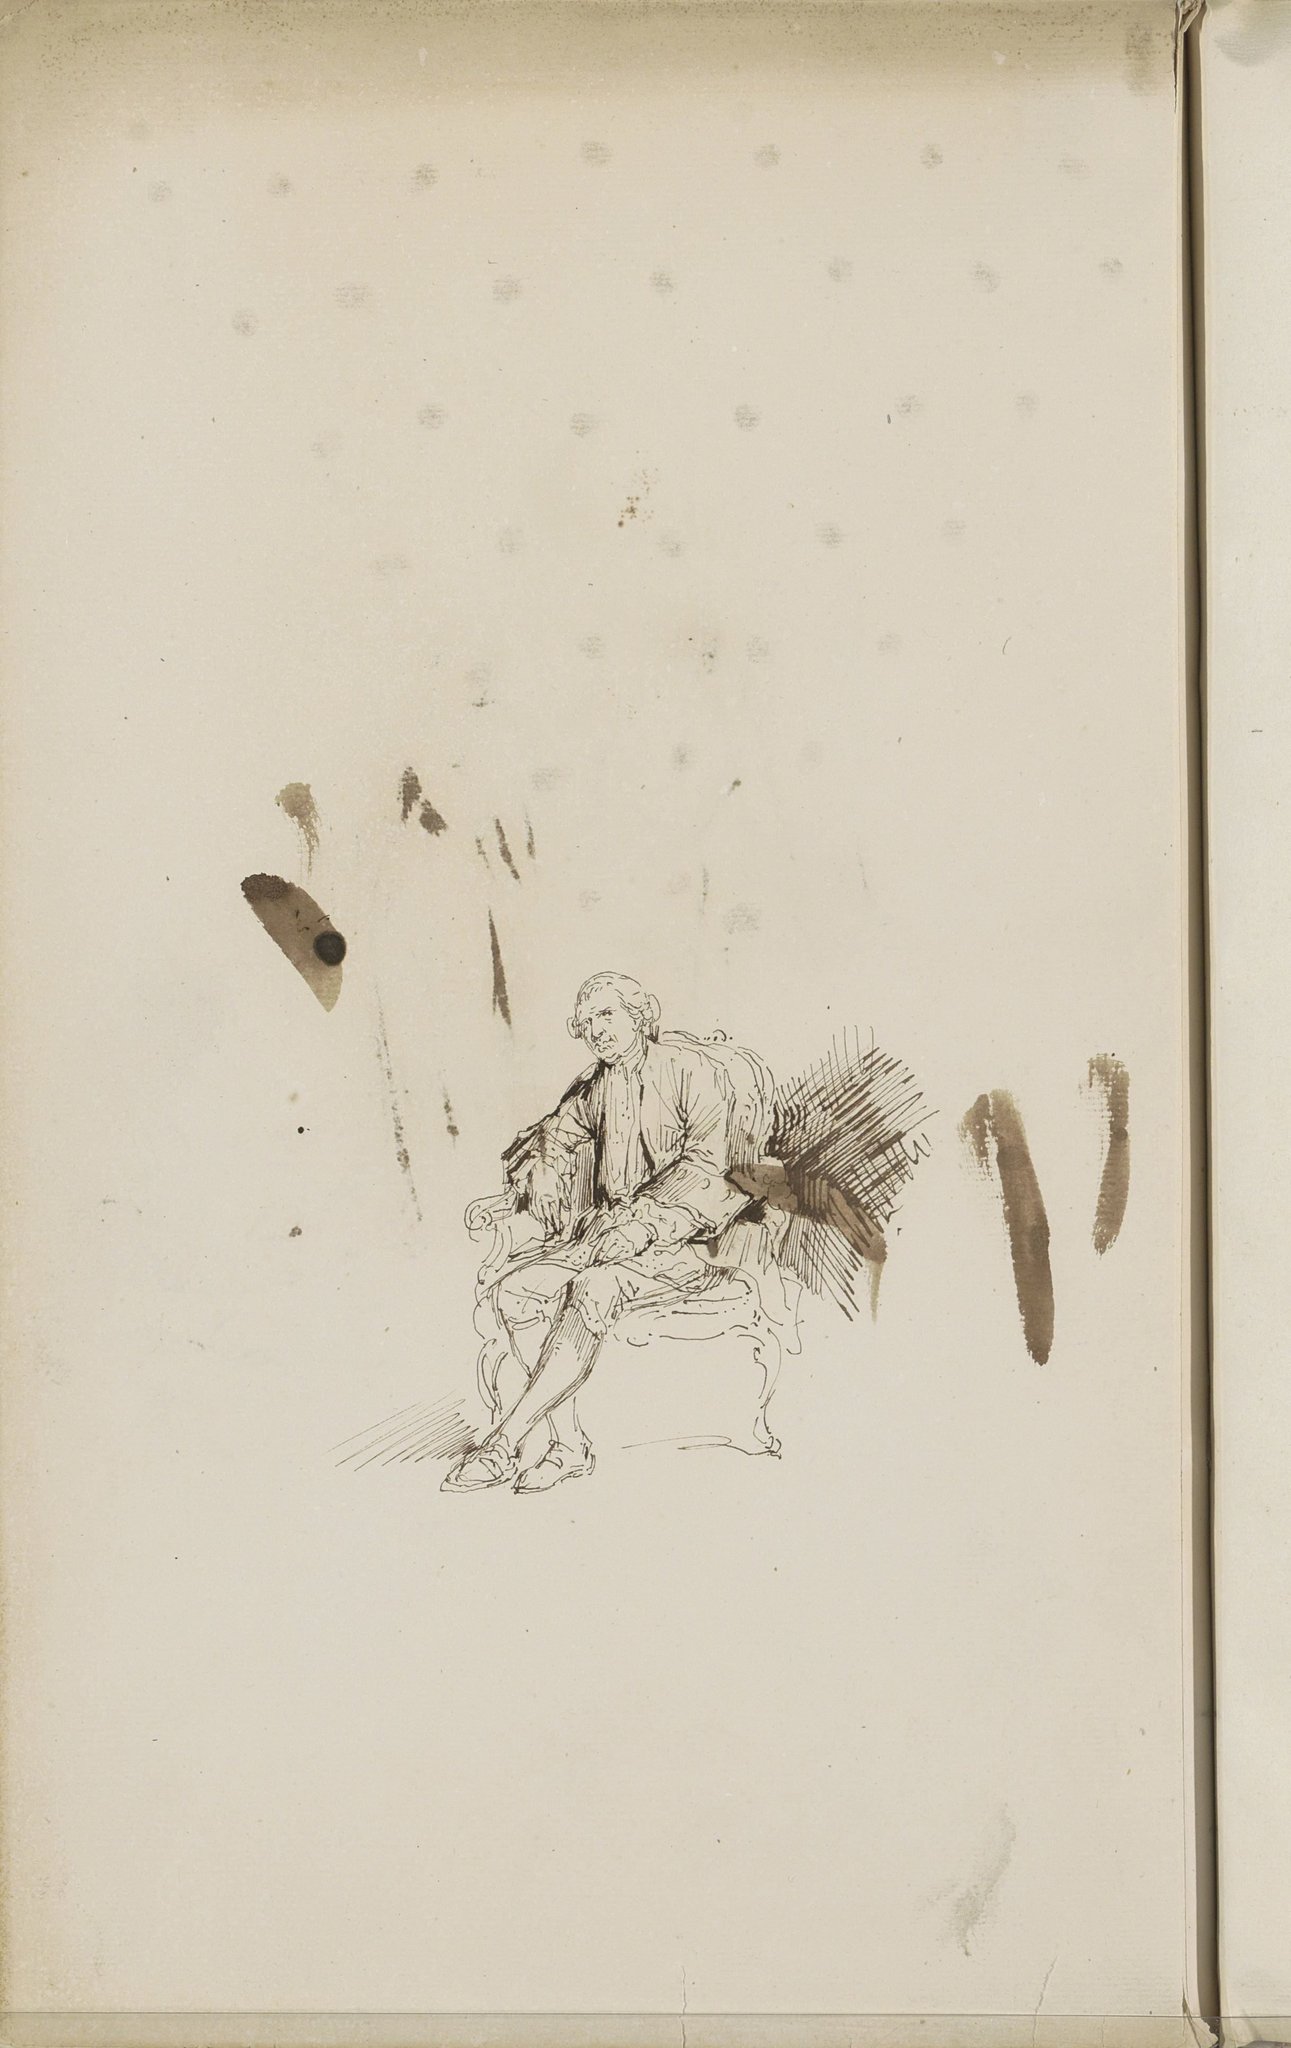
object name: album leaf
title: Zittende man in een stoel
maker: herman frederik carel ten kate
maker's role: draughtsman, painter, print maker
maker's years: 1822-1891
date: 1843-1864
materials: ink, paper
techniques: pen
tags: sitting figure, table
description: Blad 5 verso uit een verzamelalbum met 32 bladen.